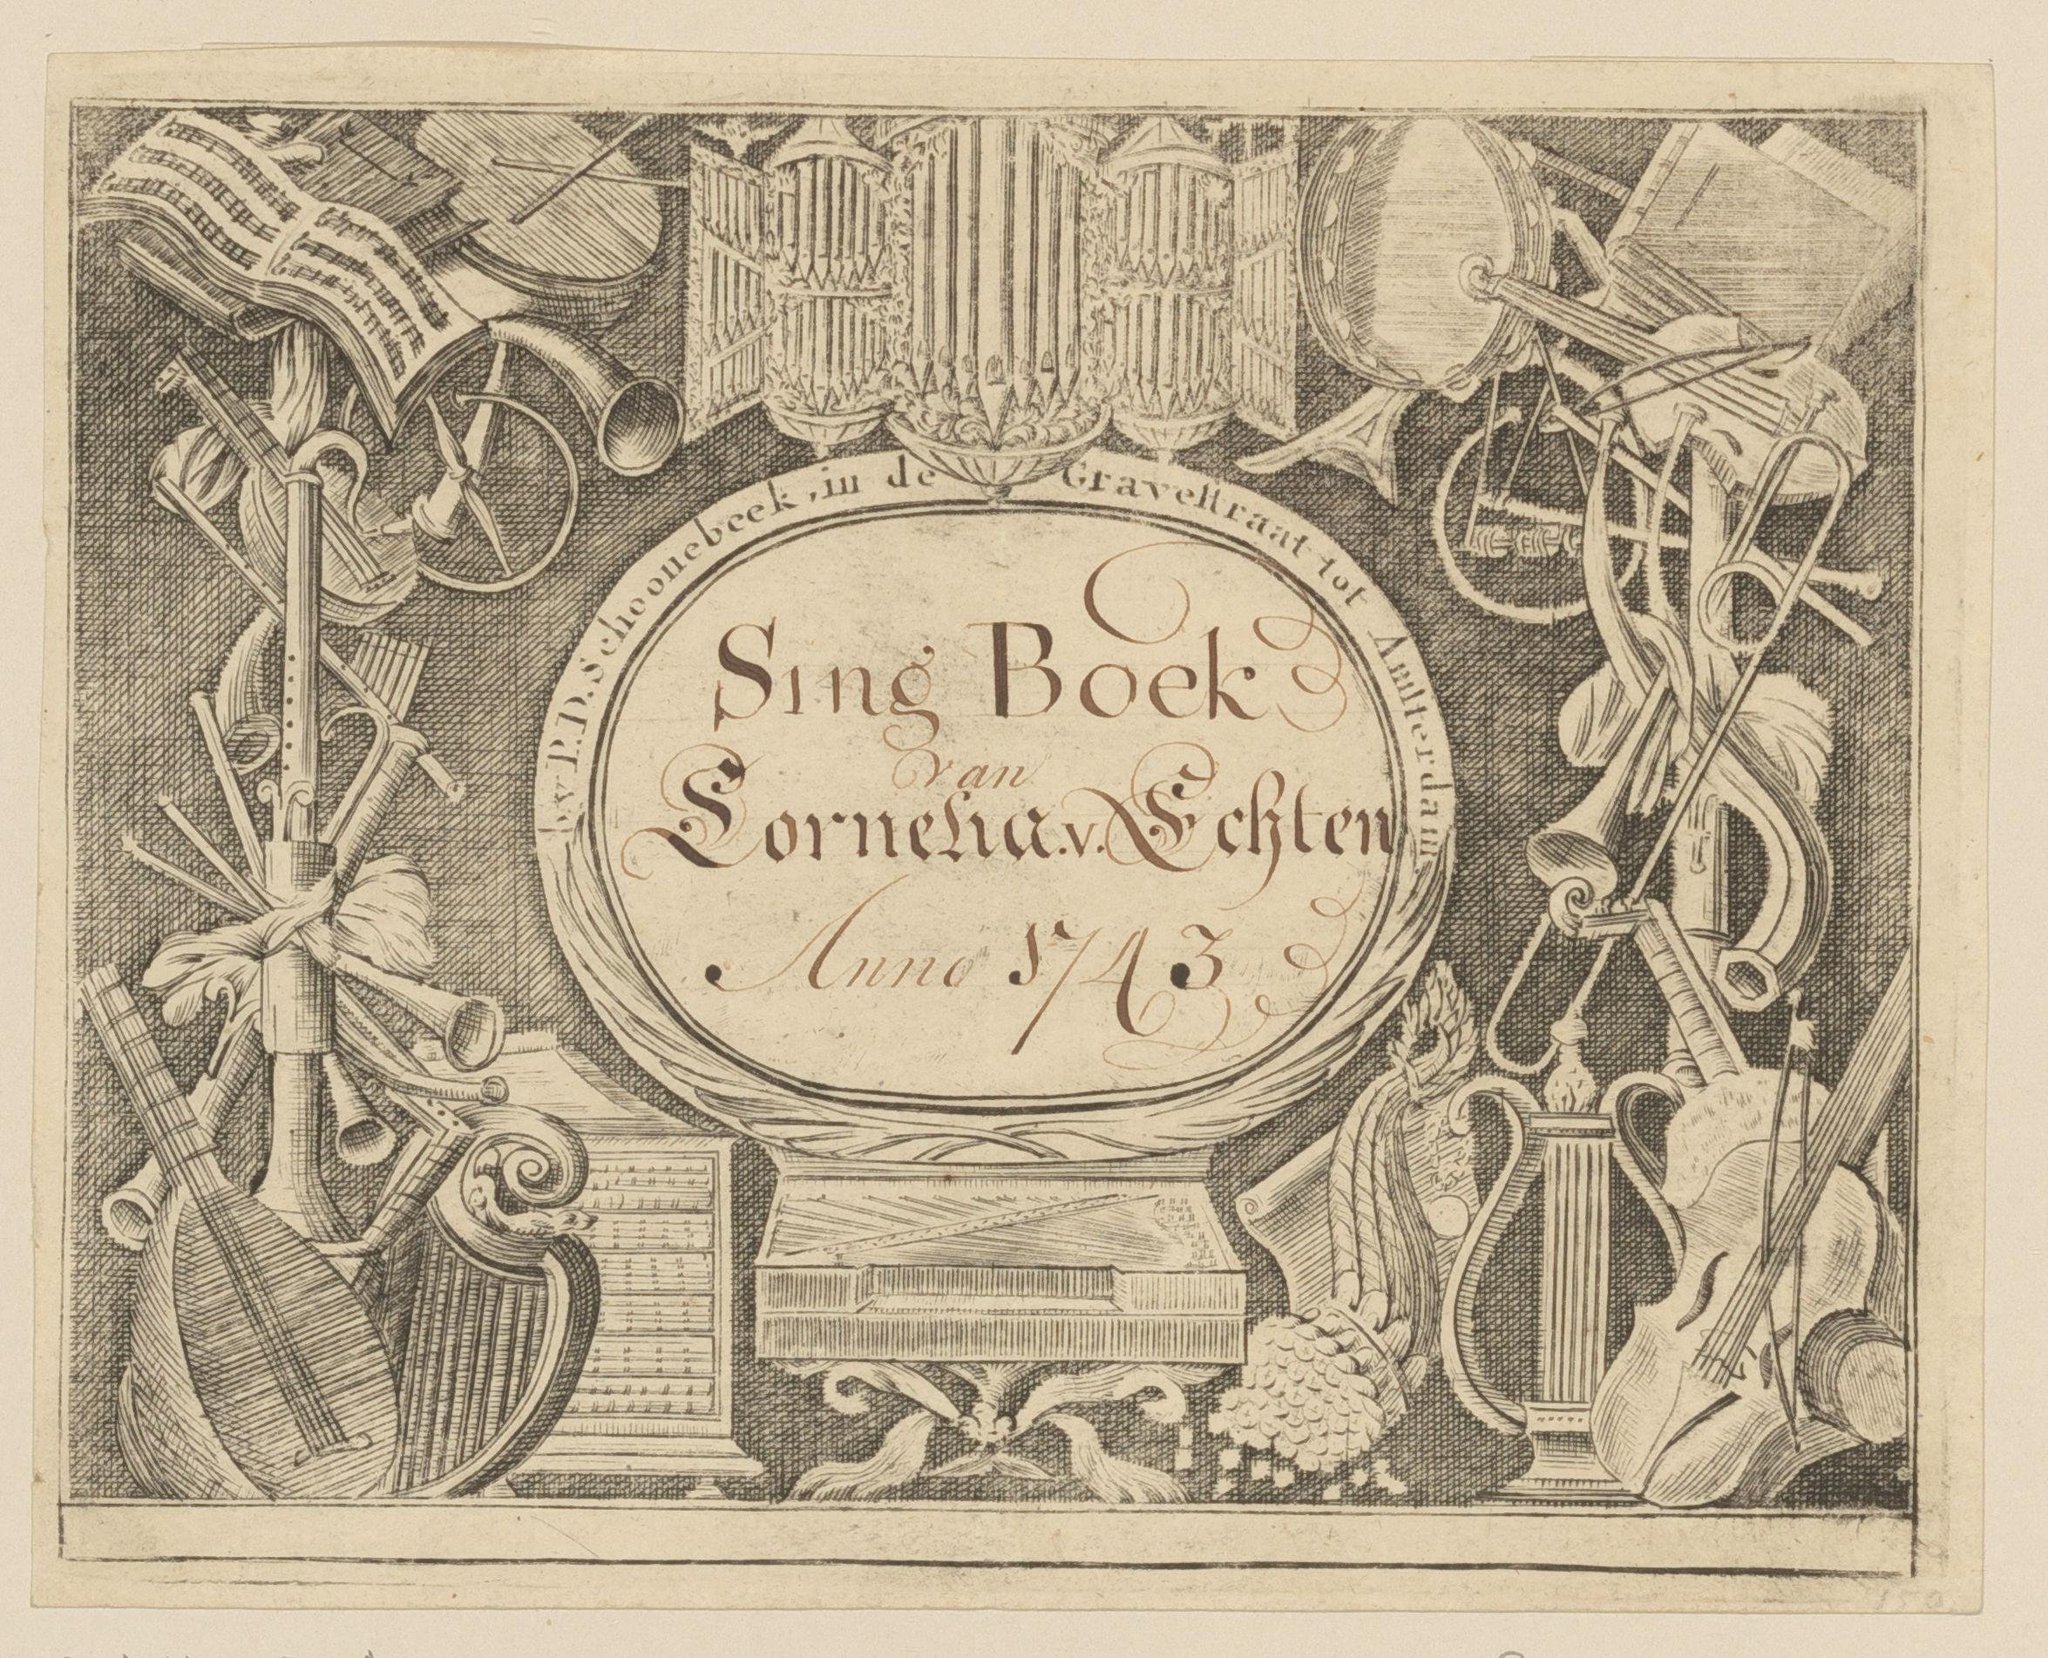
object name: print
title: Voorpagina van een liedboek van Cornelia van Echten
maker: Anonymous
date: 1743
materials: paper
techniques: engraving, etching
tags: musical instruments; group of musical instruments, amsterdam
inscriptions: collector's mark: Lugt 1641, stamp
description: Voorpagina van een van Cornelia van Echten verkocht bij P.D. Schoonebeek op de Gravestraat tot Amsterdam. Om de titel verschillende muziekinstrumenten. Onderwerpsrubrieken binnen de Atlas Zeden en Gewoonten: Handel, nijverheid en verkeer, Koophandel, Veilingen, Makelaardij en Verzekeringswezen, Oude adreskaarten van winkels en fabrieken, reclame.